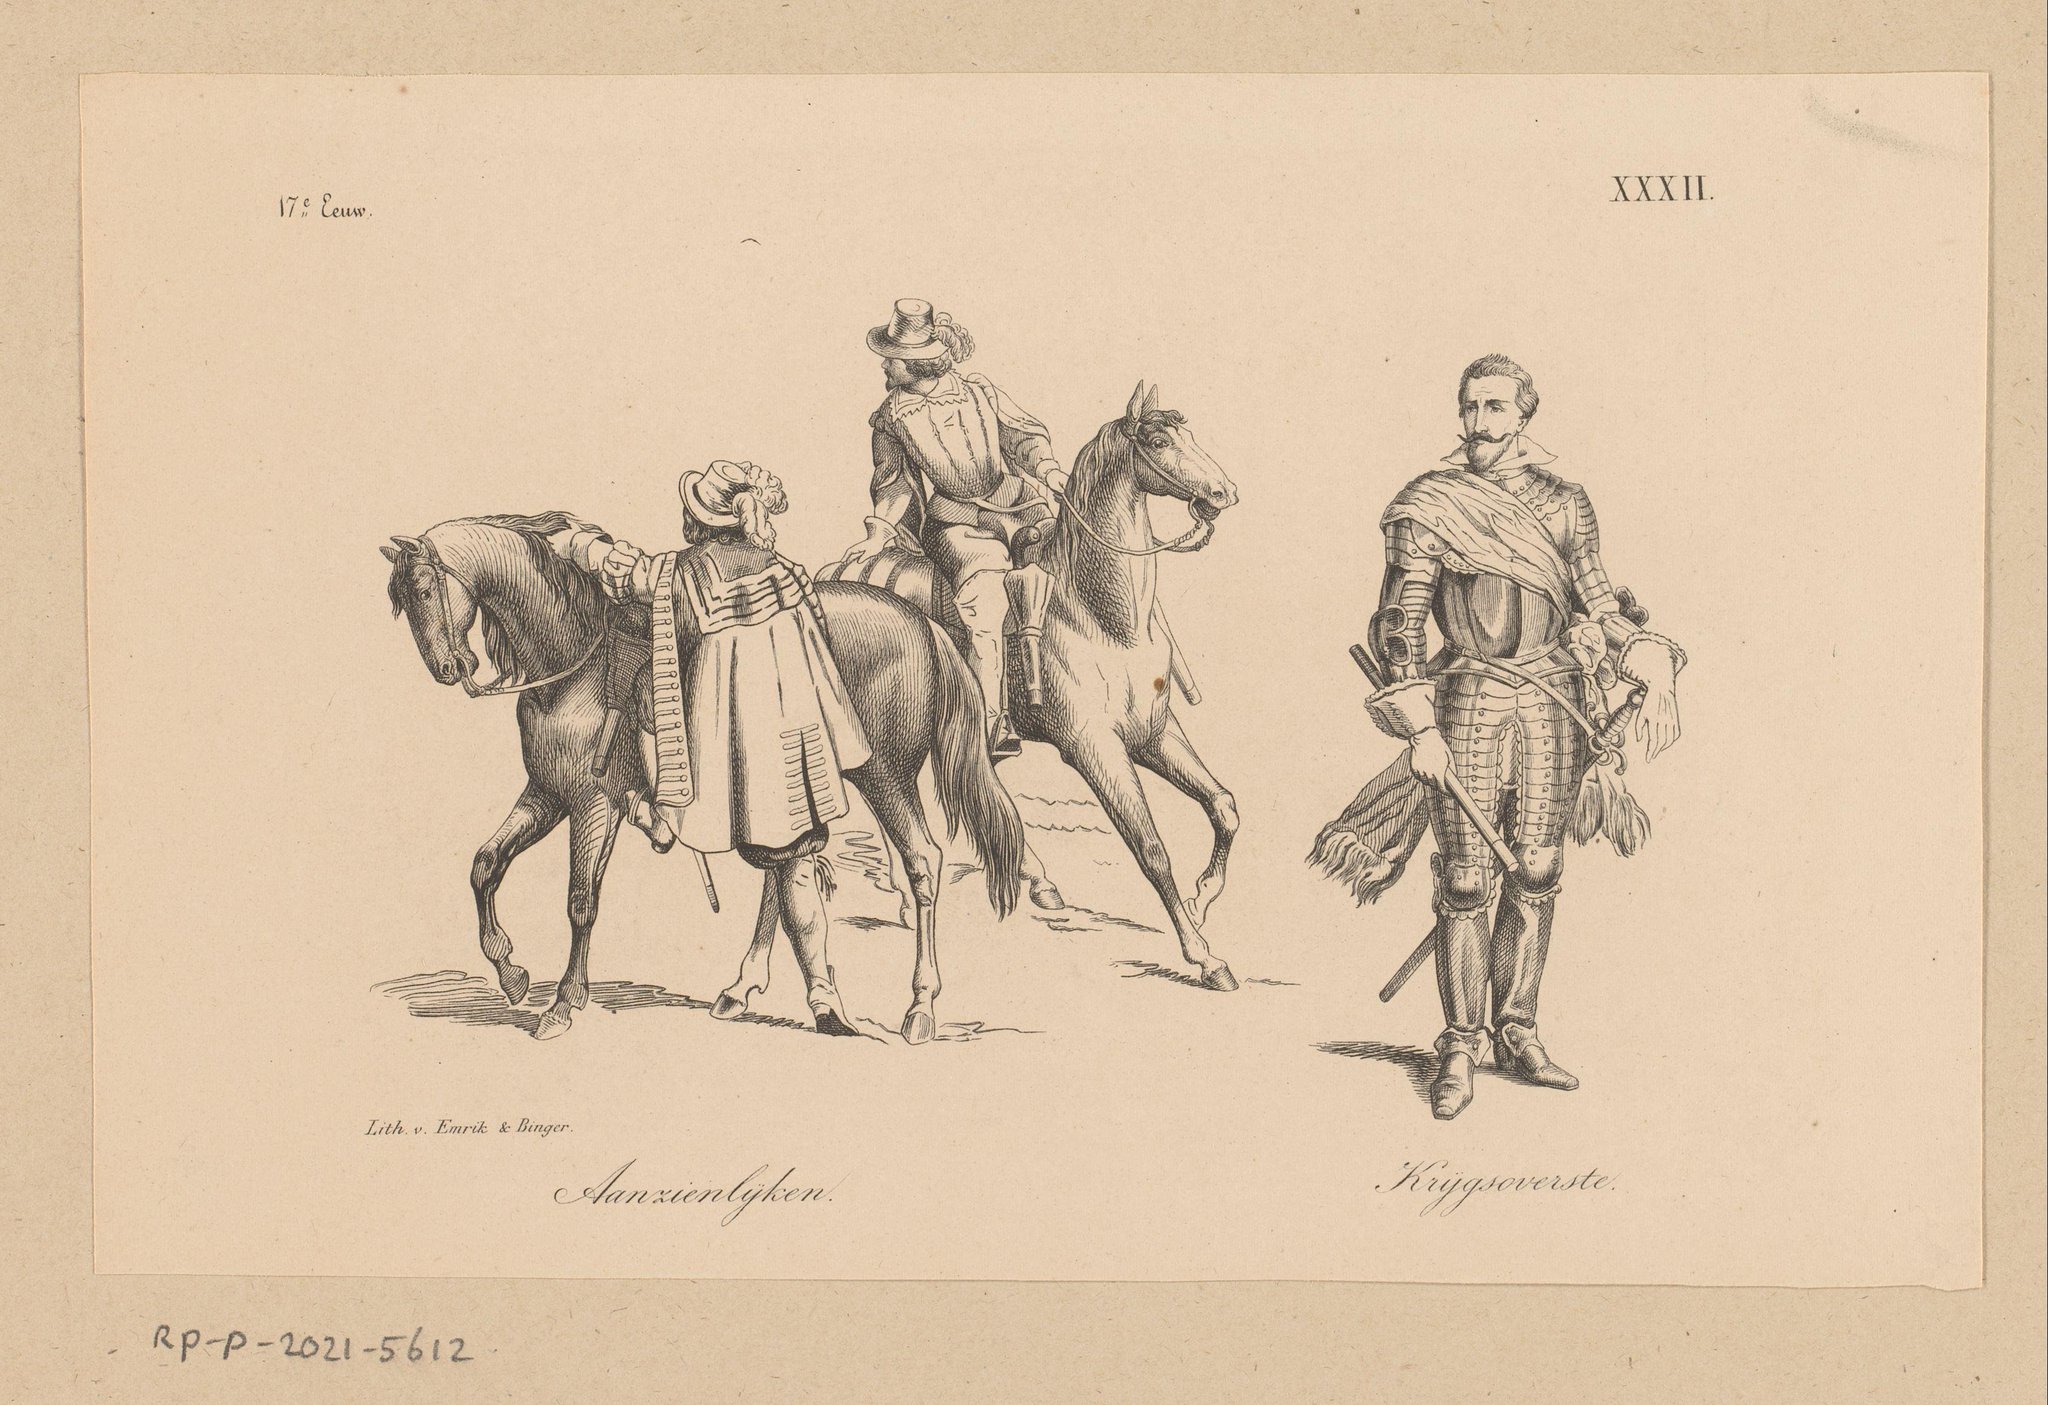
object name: print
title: Twee ruiters en bevelhebber in kleding uit de zeventiende eeuw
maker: Anonymous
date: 1857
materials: paper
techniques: lithograph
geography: haarlem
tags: riding a horse, ass, or mule; rider, horseman, commander-in-chief, general, marshal, armour, clothes, costume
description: Prent waarschijnlijk uit: Hofdijk, Willem Jacob. Schets van de geschiedenis der Nederlanden. Amsterdam: Gebroeders Binger, 1857.